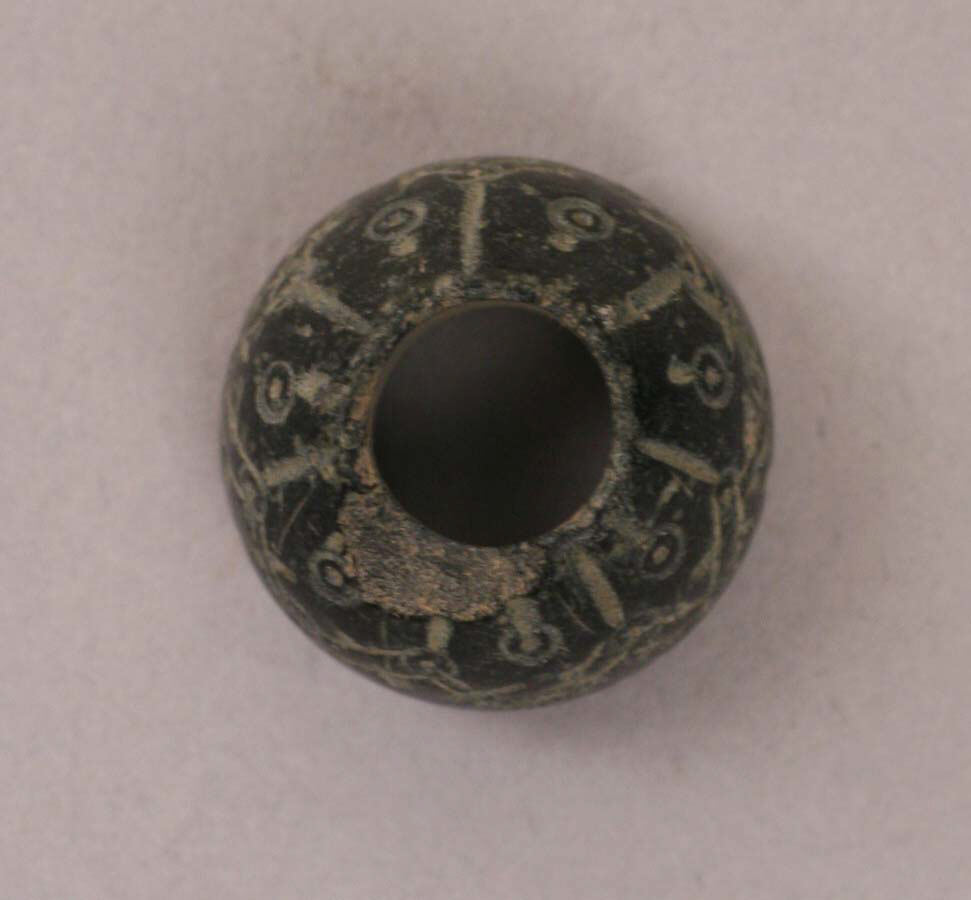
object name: button or bead or spindle whorl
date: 701-1000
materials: stone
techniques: incising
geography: iran